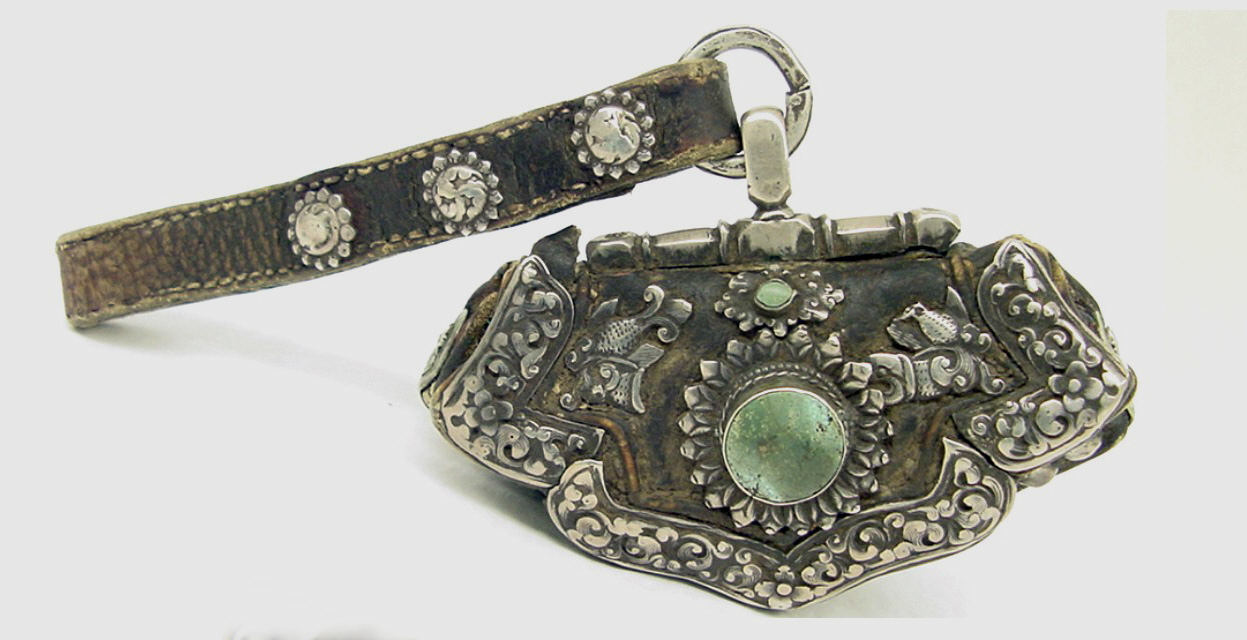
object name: pouch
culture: tibetan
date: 1801-1900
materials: leather, silver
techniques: inlay, repoussé